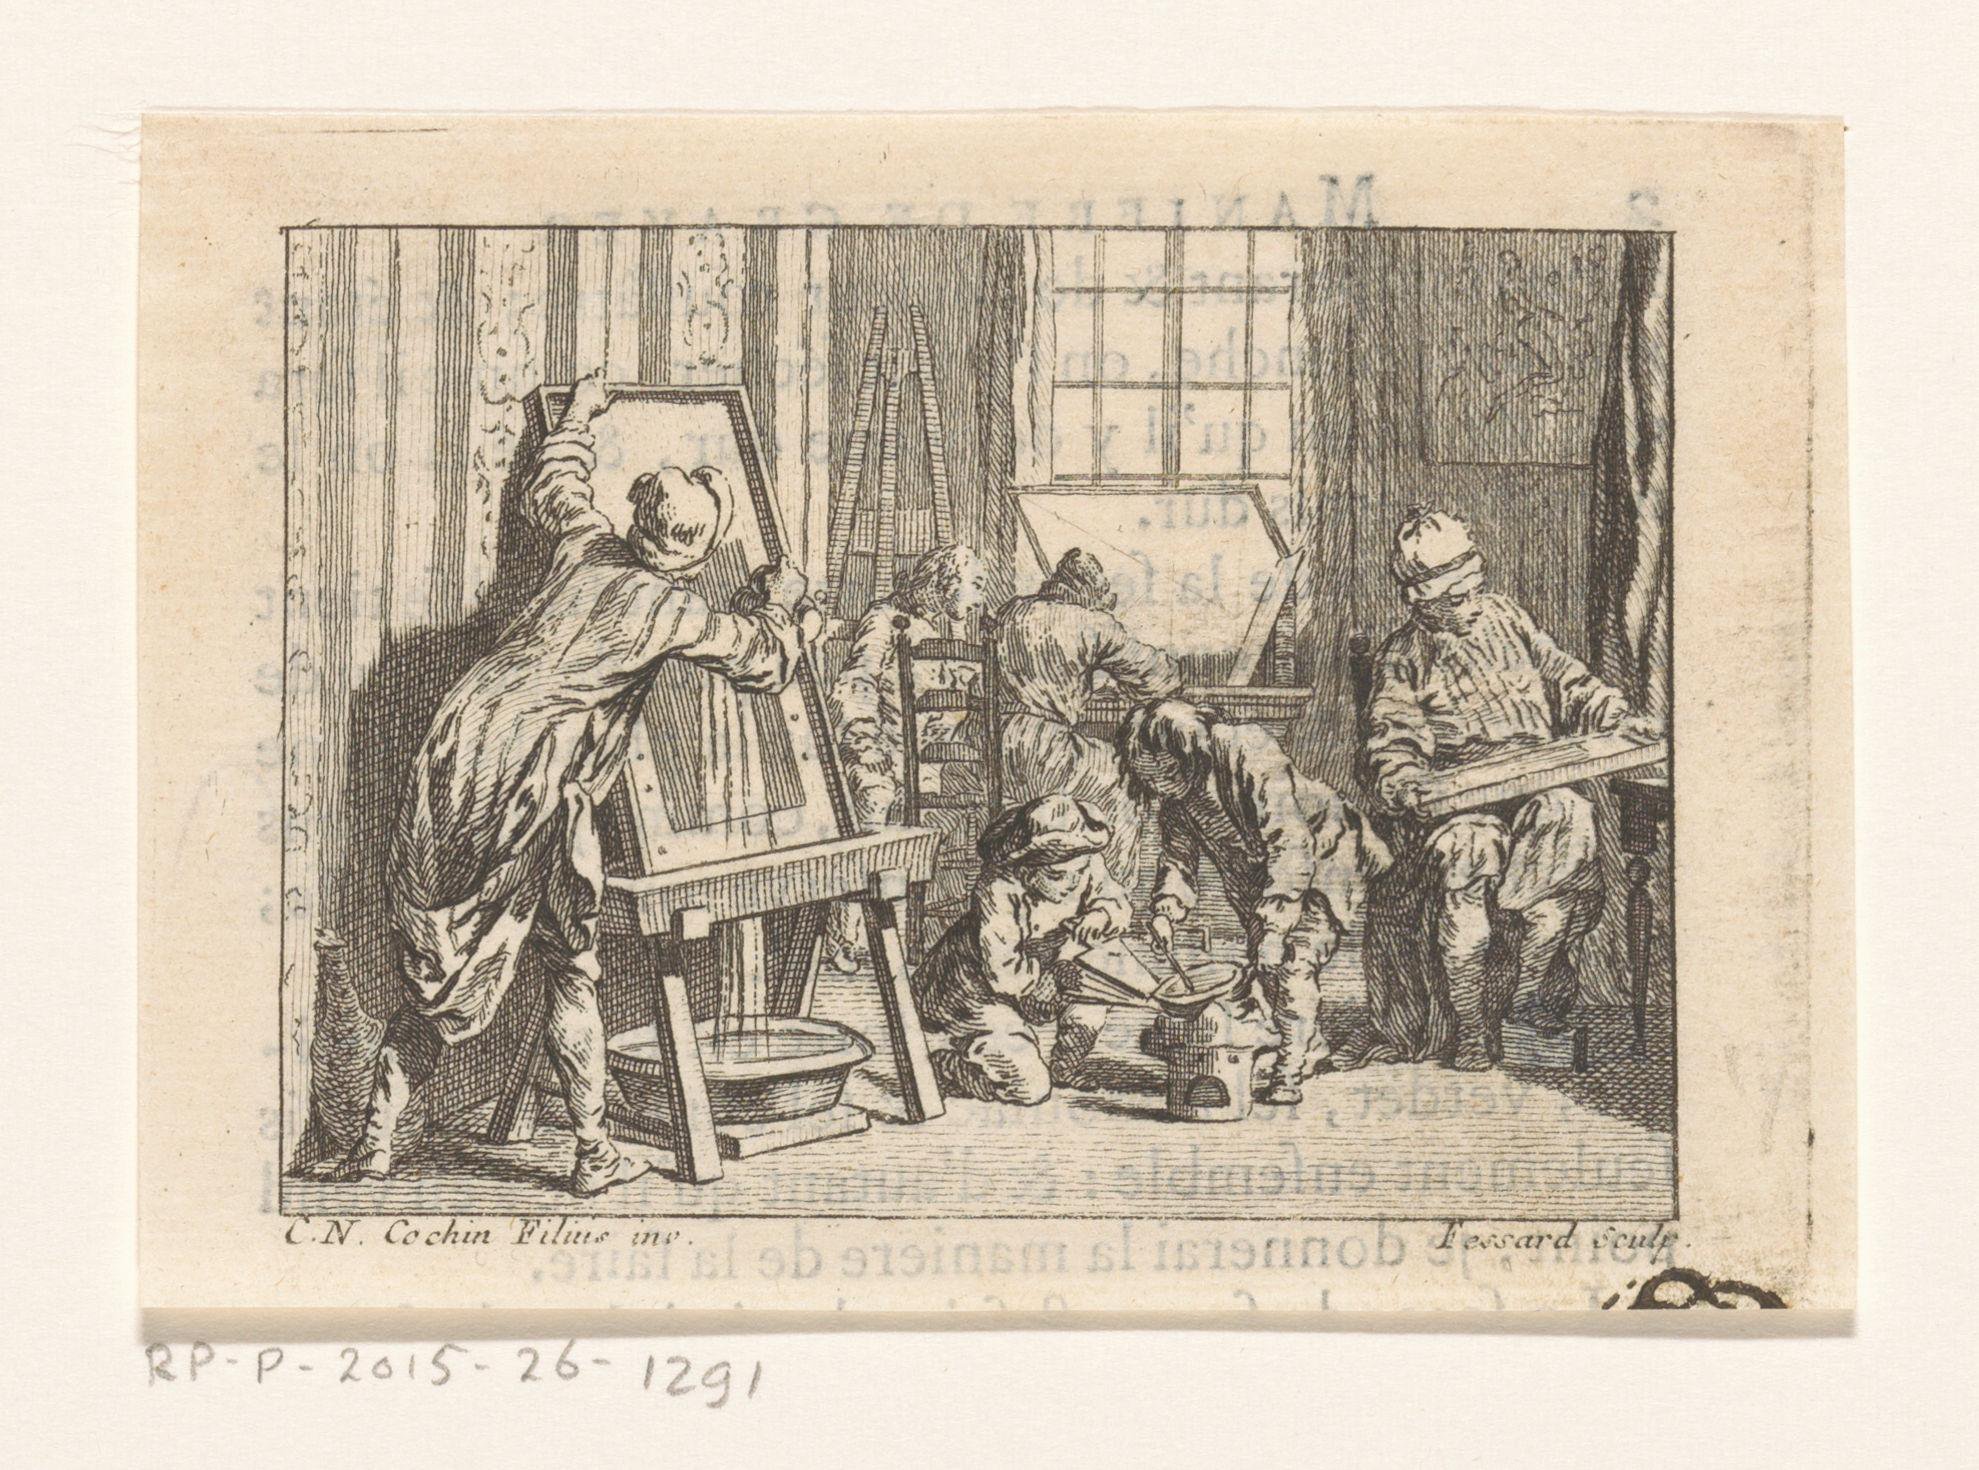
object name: print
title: Atelier van een prentmaker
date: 1745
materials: paper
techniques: etching, letterpress printing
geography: paris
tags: engraver, etcher, artist at work, in his workshop (+ graphic arts), tools, implements of graphic artist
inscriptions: collector's mark: Lugt 2228, collector's mark: Lugt 4780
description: Atelier van een prentmaker met links een man die etswater over een koperplaat giet. In het midden verwarmen twee leerlingen een pan met inkt. In de achtergrond is een prentmaker aan het werk.